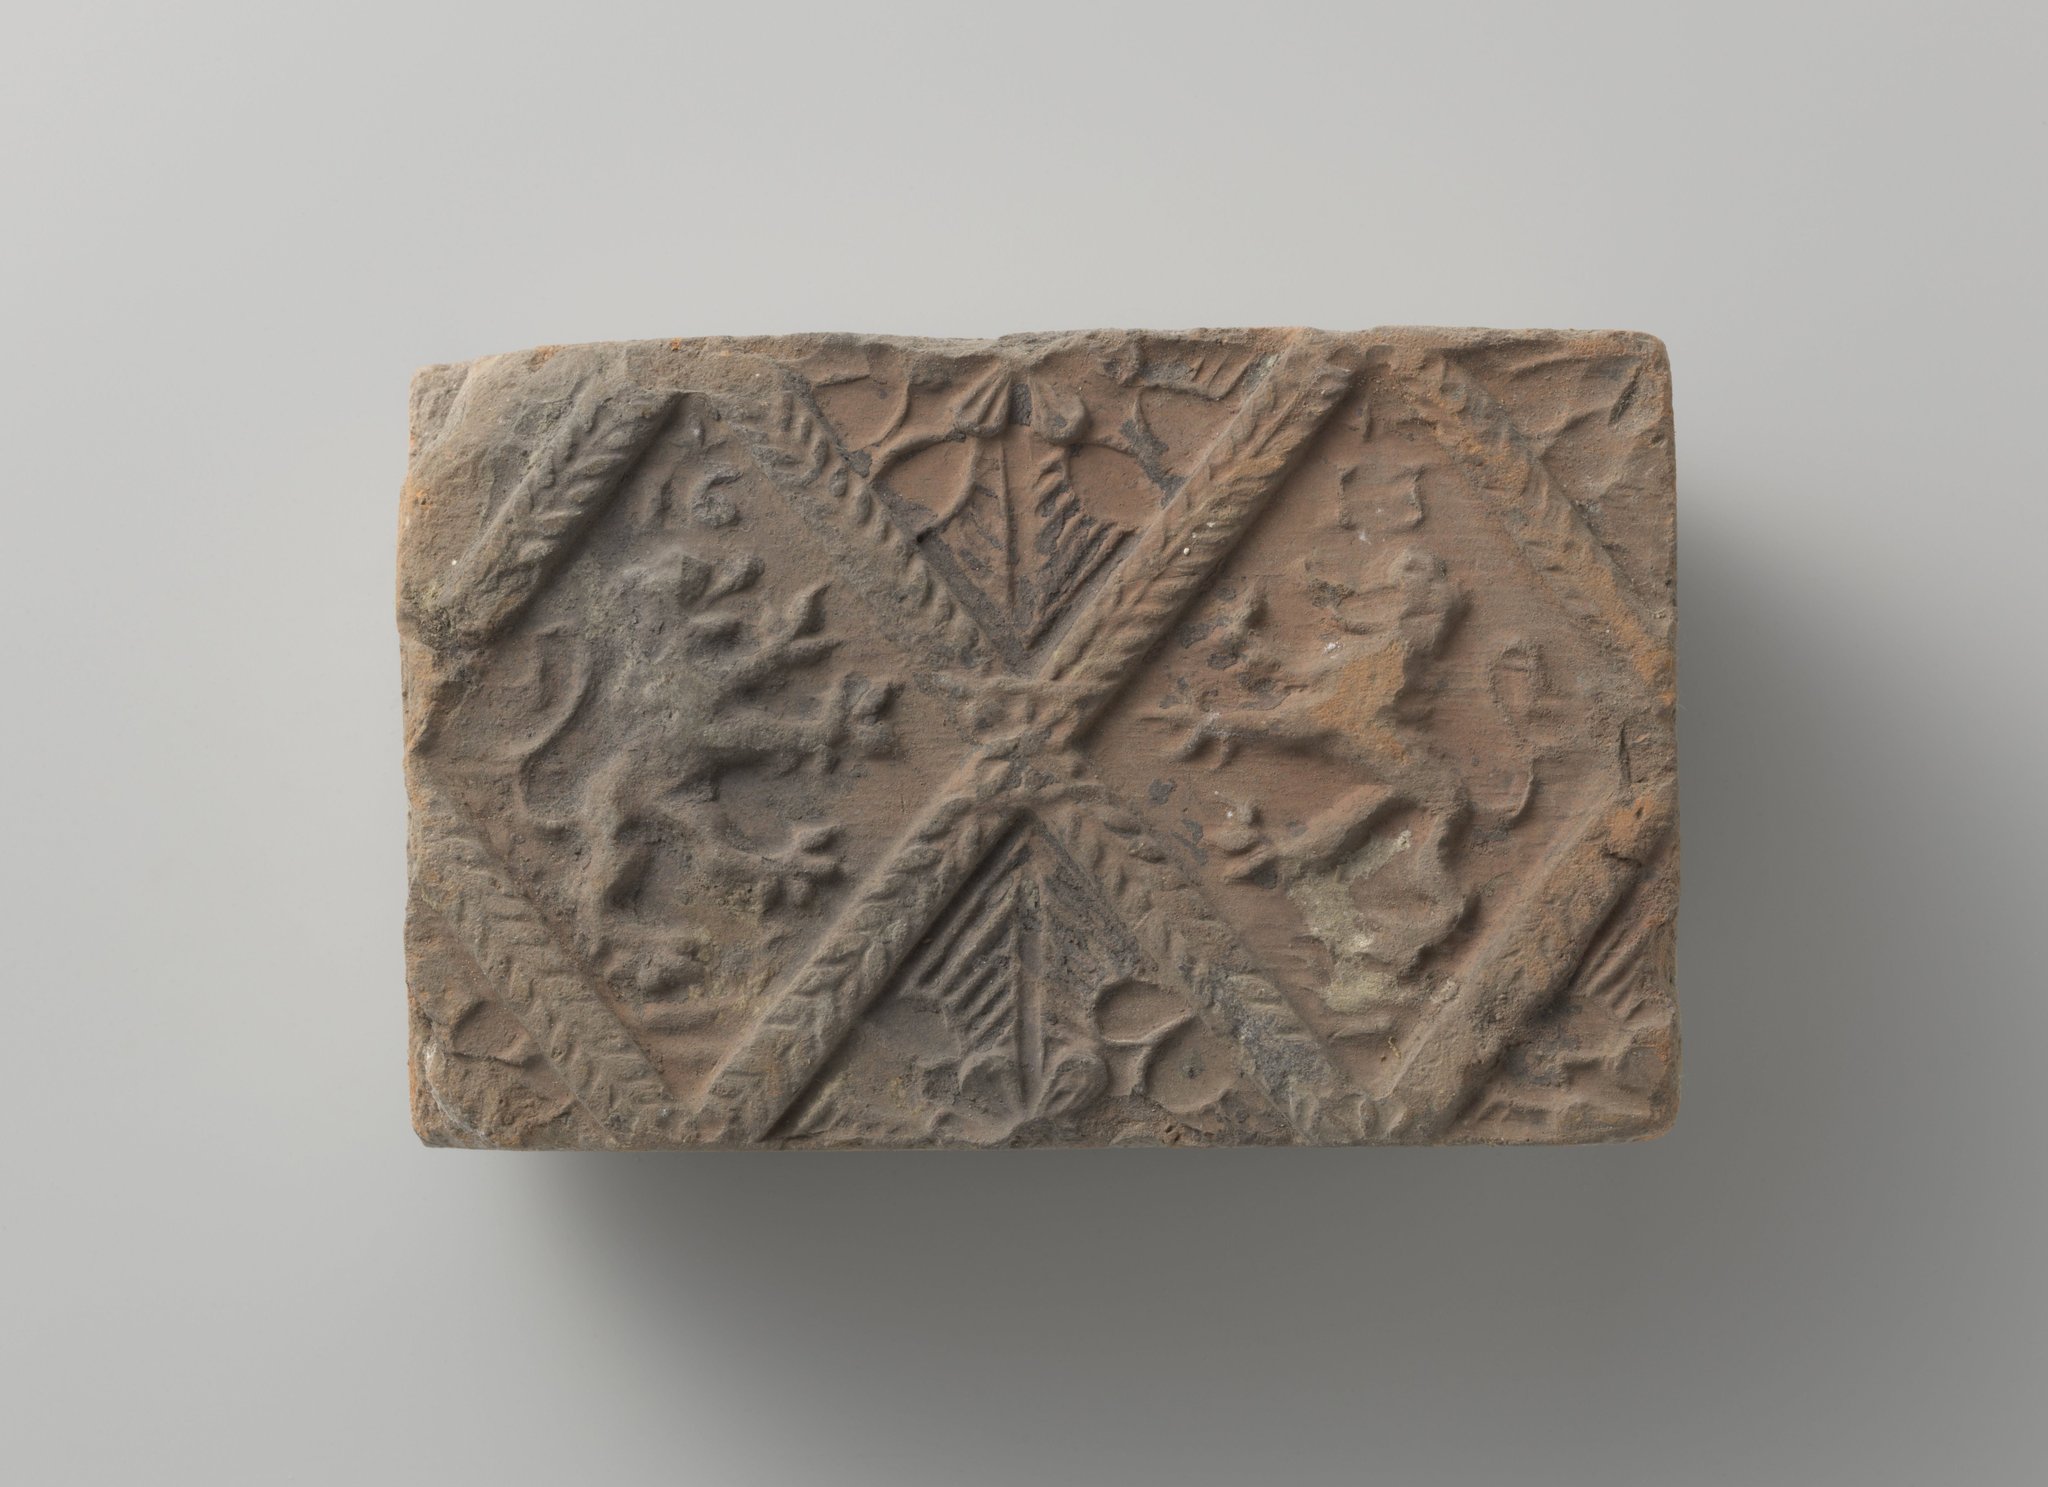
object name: hearthstone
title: Haardsteen met voorstelling van twee klimmende leeuwen, geplaatst in twee ruiten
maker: Anonymous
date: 1610-1620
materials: earthenware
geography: southern netherlands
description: Haardsteen met voorstelling van twee klimmende leeuwen, geplaatst in twee ruiten en vergezeld van het jaartal 1611 of 1613. De halve en kwart ruiten aan de boven- en onderkant zijn opgevuld met een ruitvormige bloem.